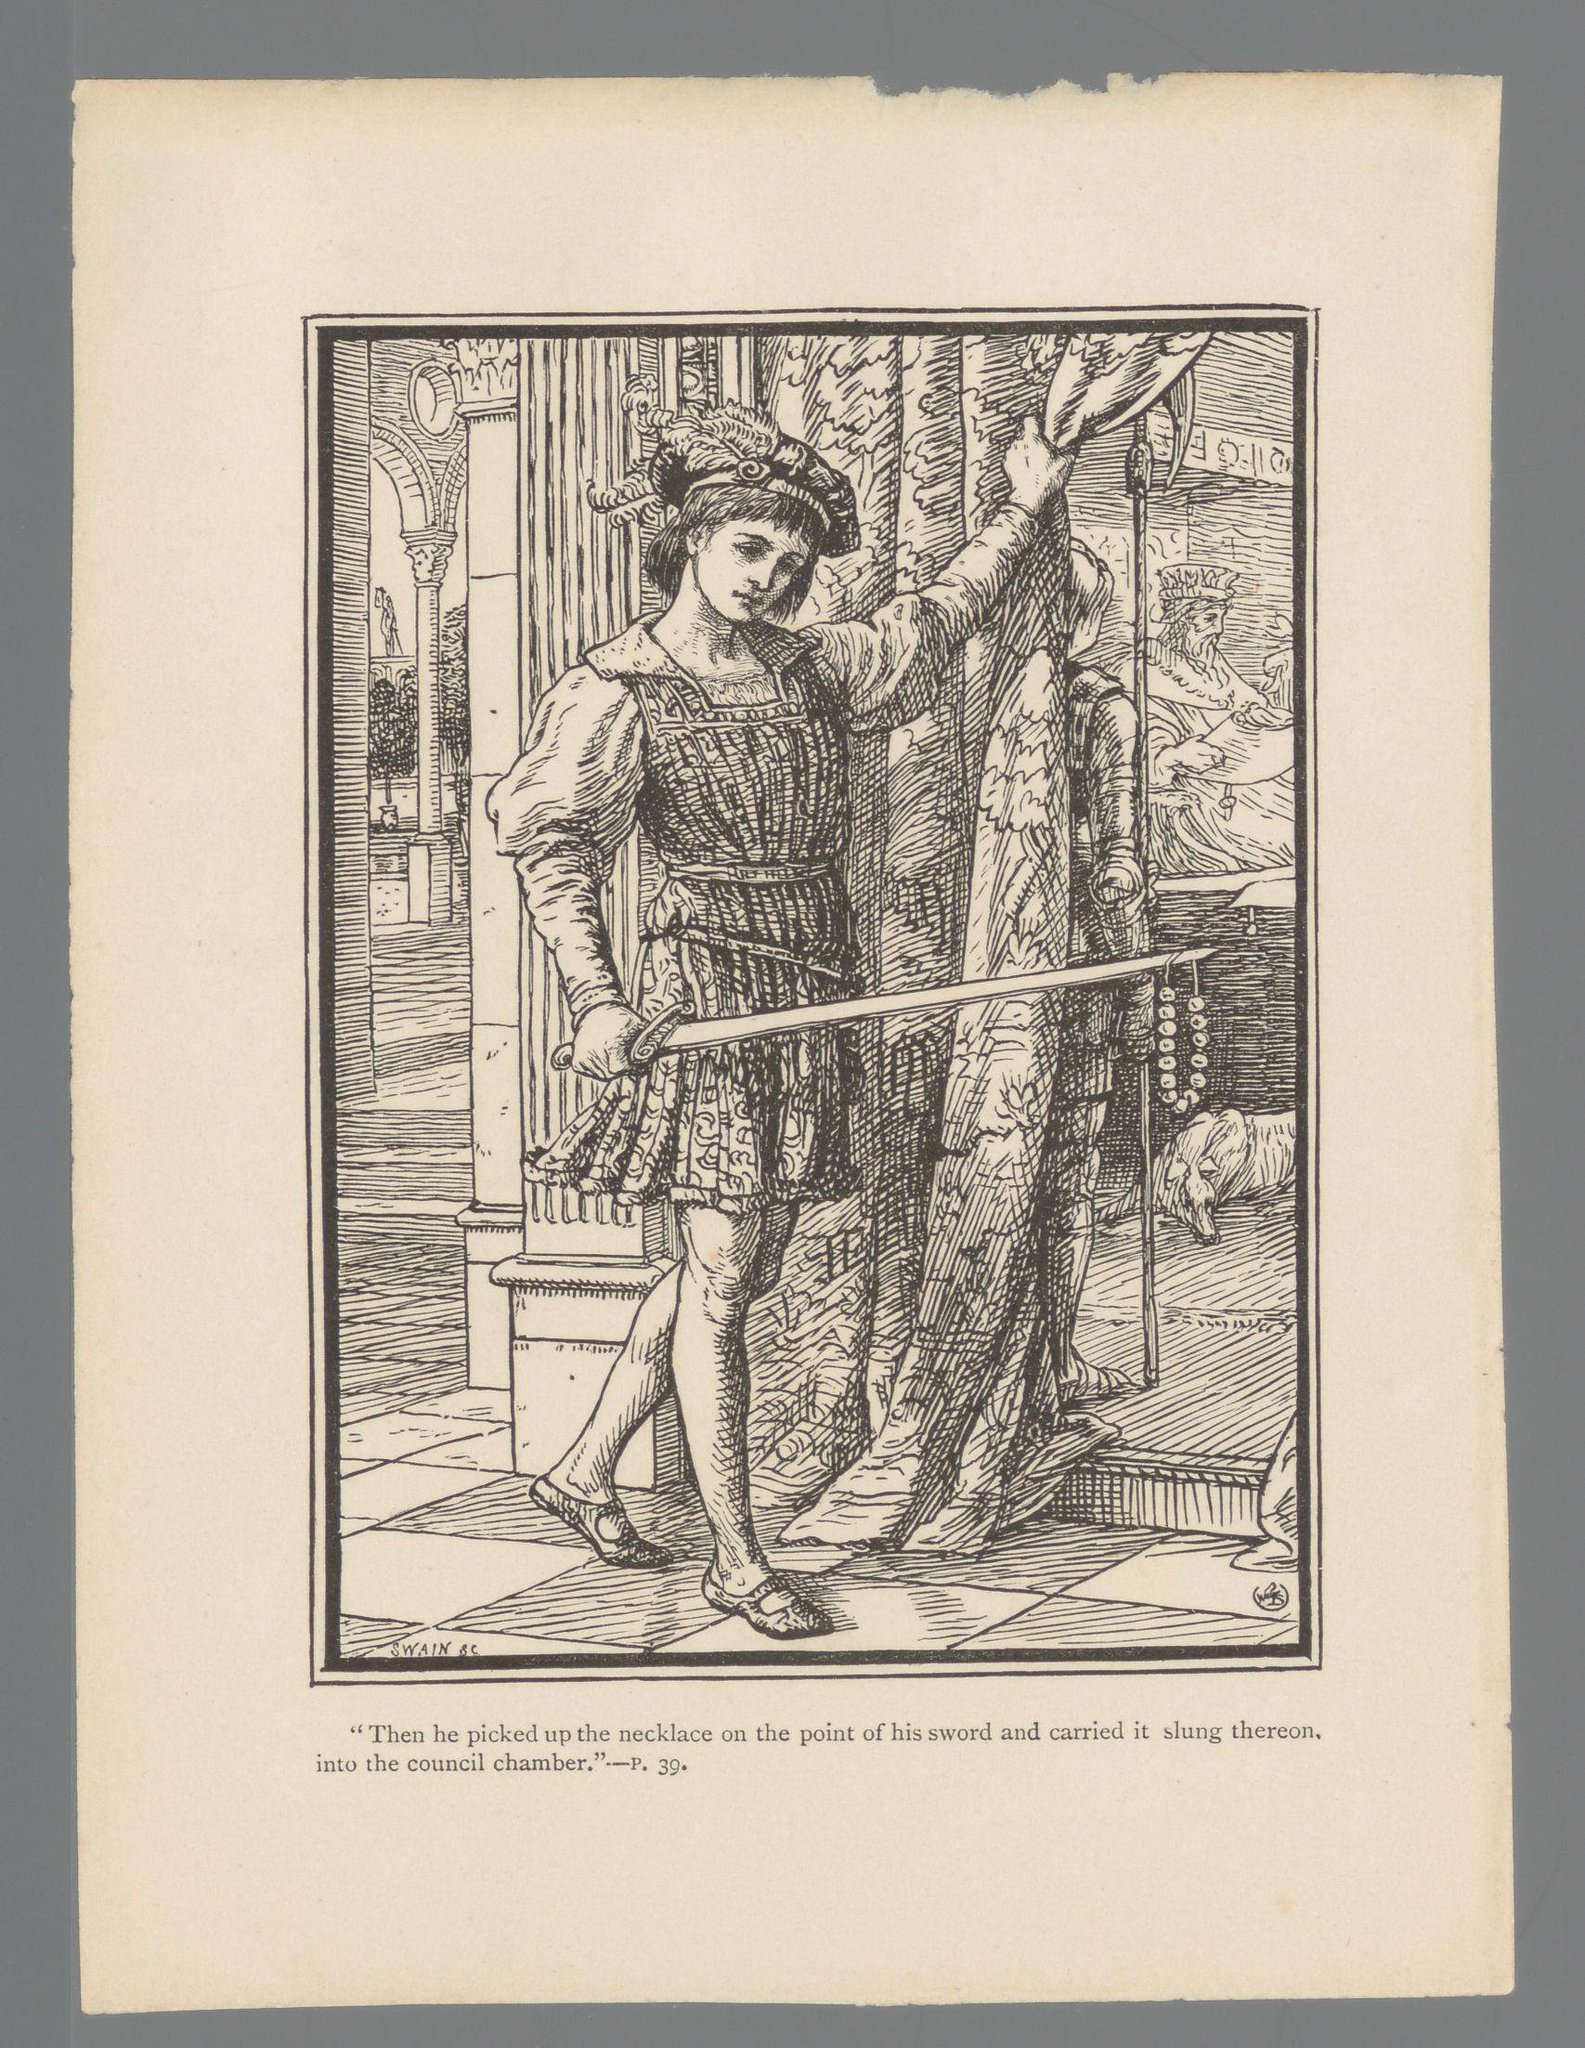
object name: book illustration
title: Man met zwaard opent een gordijn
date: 1886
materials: paper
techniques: letterpress printing, engraving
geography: london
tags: curtains, adult man, hacking and thrusting weapons: sword, interior of the house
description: Prent uit: Morgan, Mary de. The necklace of princess Fiorimonde and other stories by May de Morgan. Londen: Macmillan & Co., 1886.